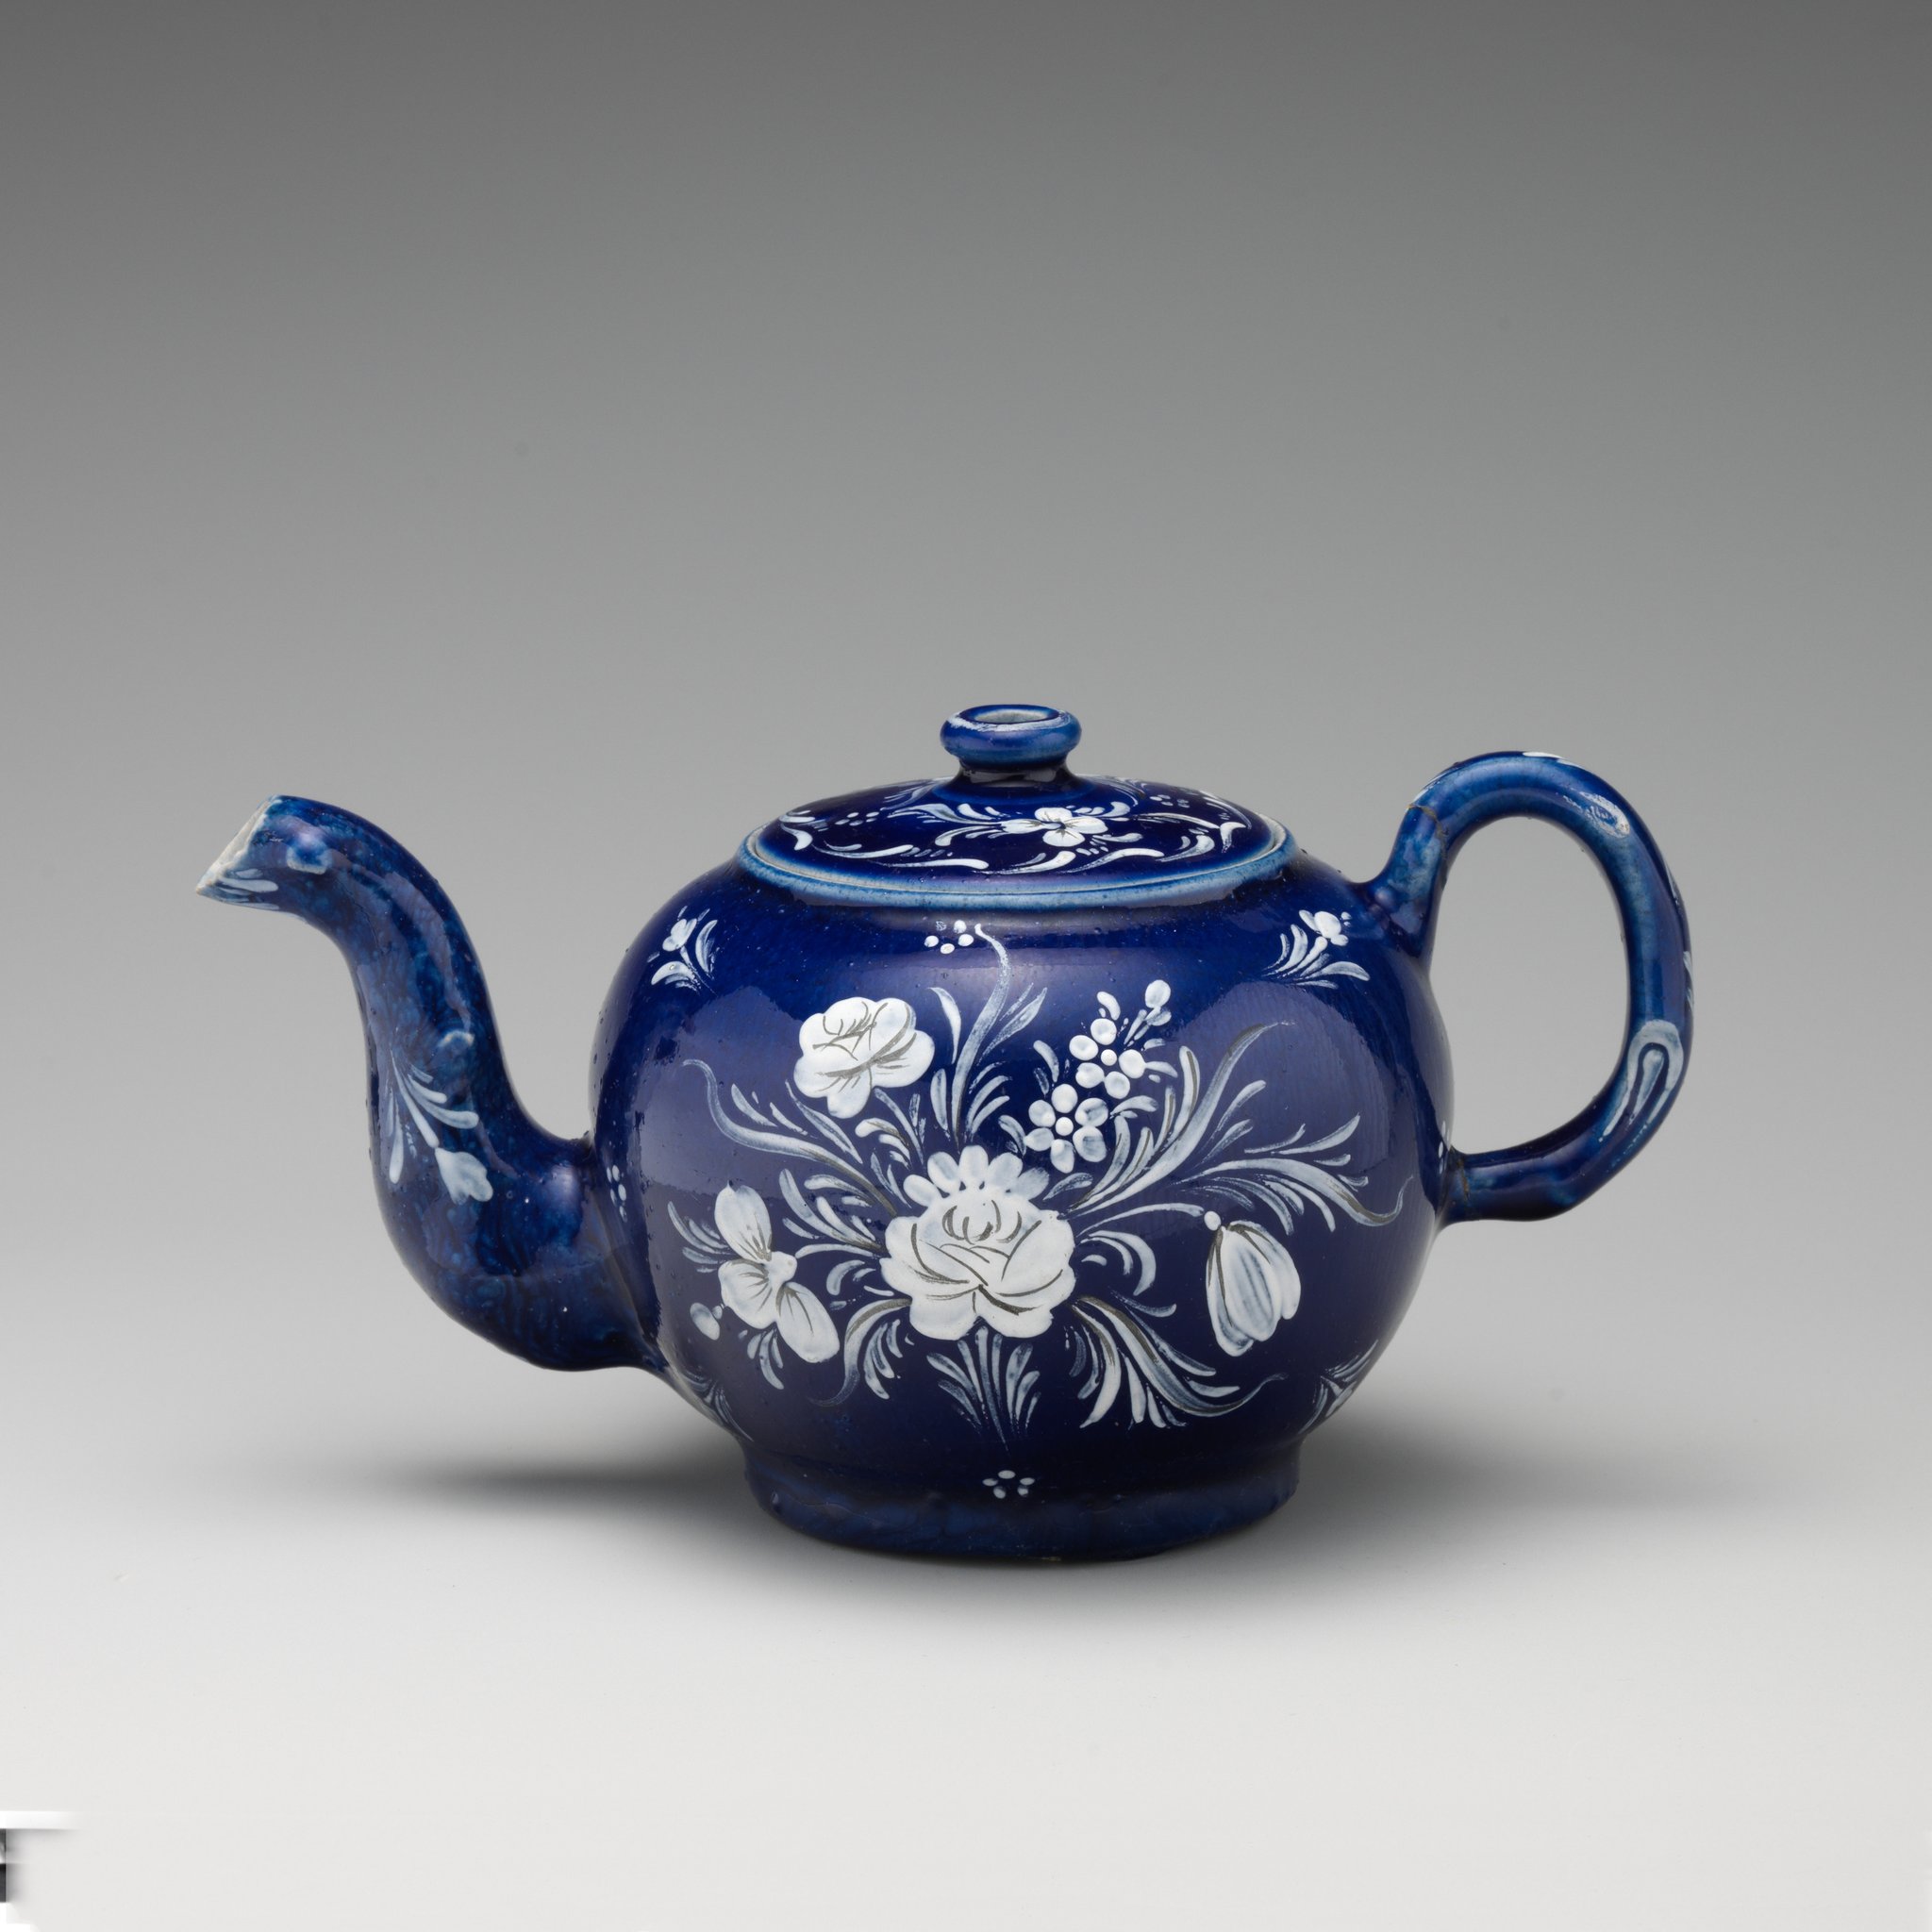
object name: teapot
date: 1765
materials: stoneware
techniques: salt glaze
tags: flowers